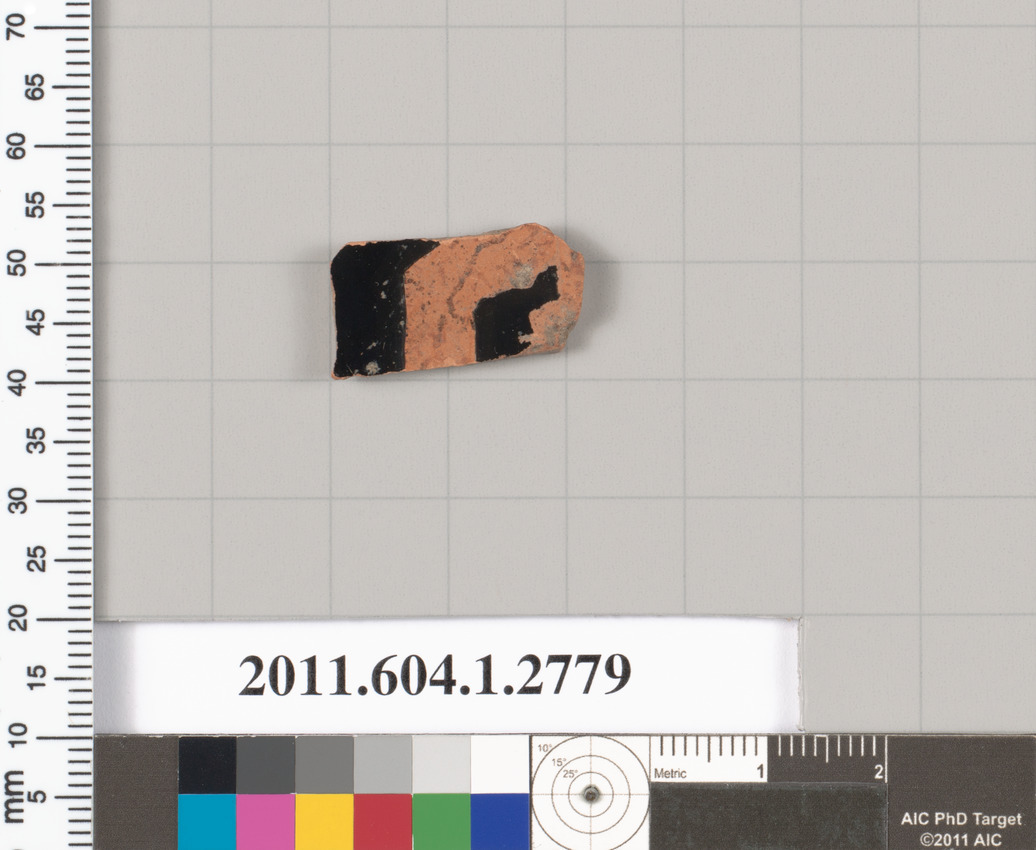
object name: kylix fragment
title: Terracotta fragment of a kylix (drinking cup)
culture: greek, attic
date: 500-401 BCE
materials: terracotta